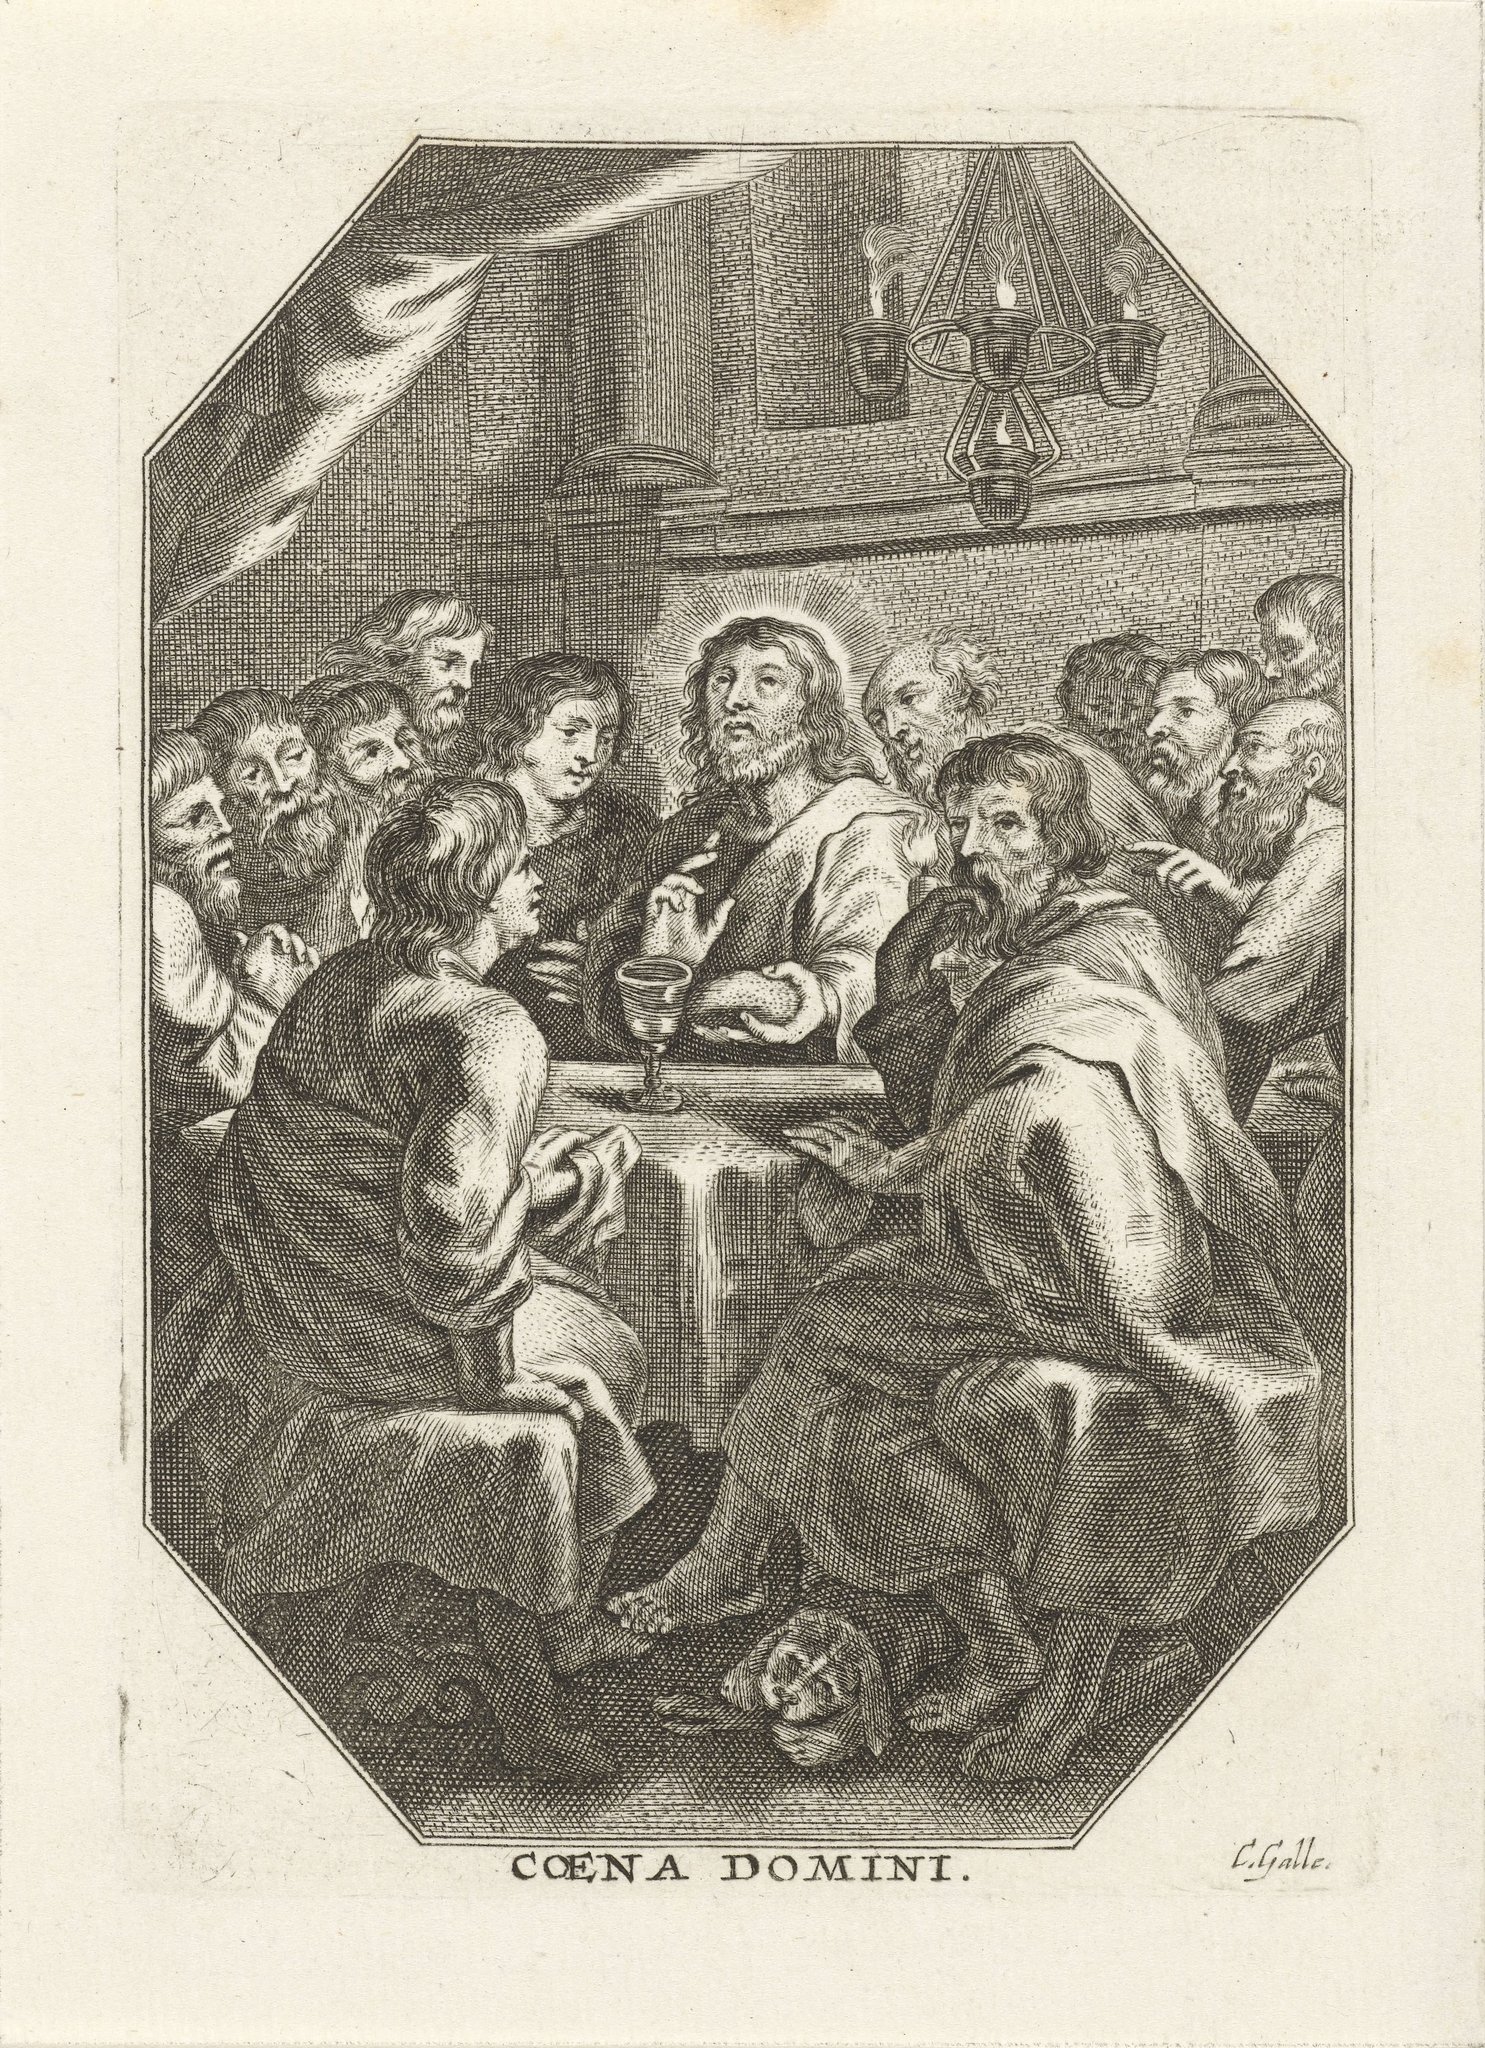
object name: print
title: Laatste avondmaal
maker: cornelis galle (i)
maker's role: print maker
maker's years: 1576-1650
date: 1586-1650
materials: paper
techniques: engraving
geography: southern netherlands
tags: communion of the apostles: christ giving bread (host) and/or wine to the (standing) apostles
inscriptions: collector's mark: Lugt 2228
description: Christus zit met zijn discipelen aan tafel voor het laatste avondmaal. Hij houdt het brood in handen en spreekt een gebed. Tweede prent uit een serie van 13, met voorstellingen uit het lijdensverhaal van Christus.